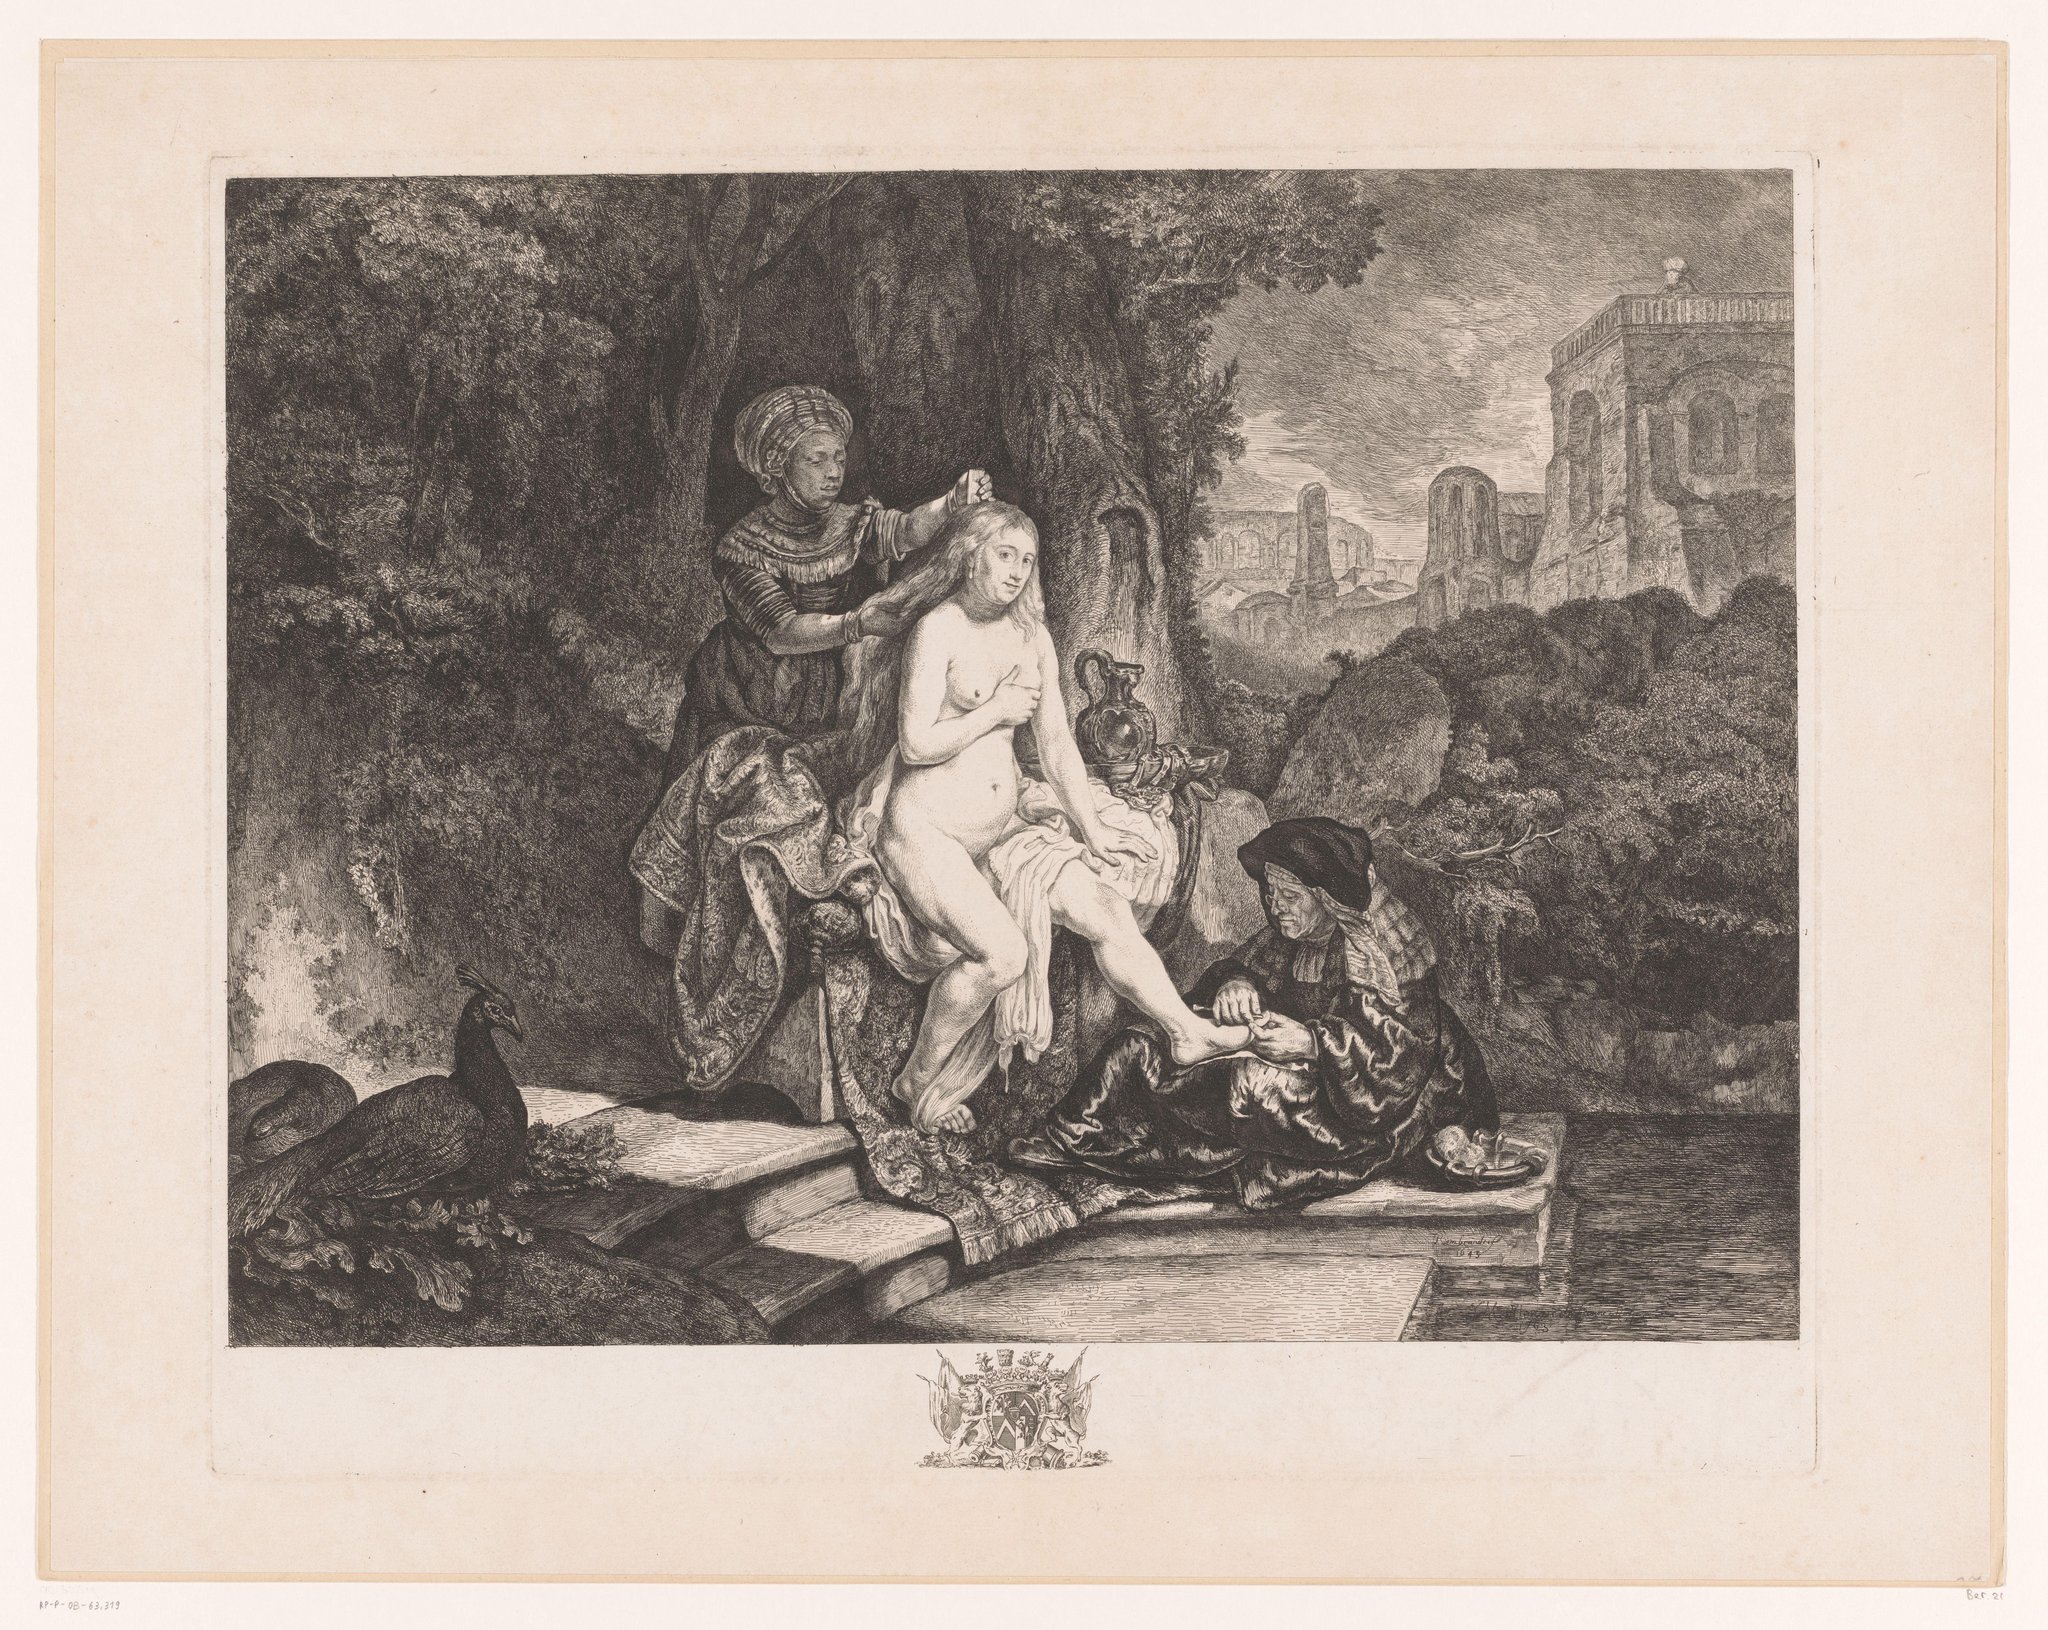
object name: print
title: David & Bethzabée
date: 1763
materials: paper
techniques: engraving, etching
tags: david, from the roof (or balcony) of his palace, sees bathsheba bathing, armorial bearing, heraldry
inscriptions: collector's mark: Lugt 789a, collector's mark: Lugt 240